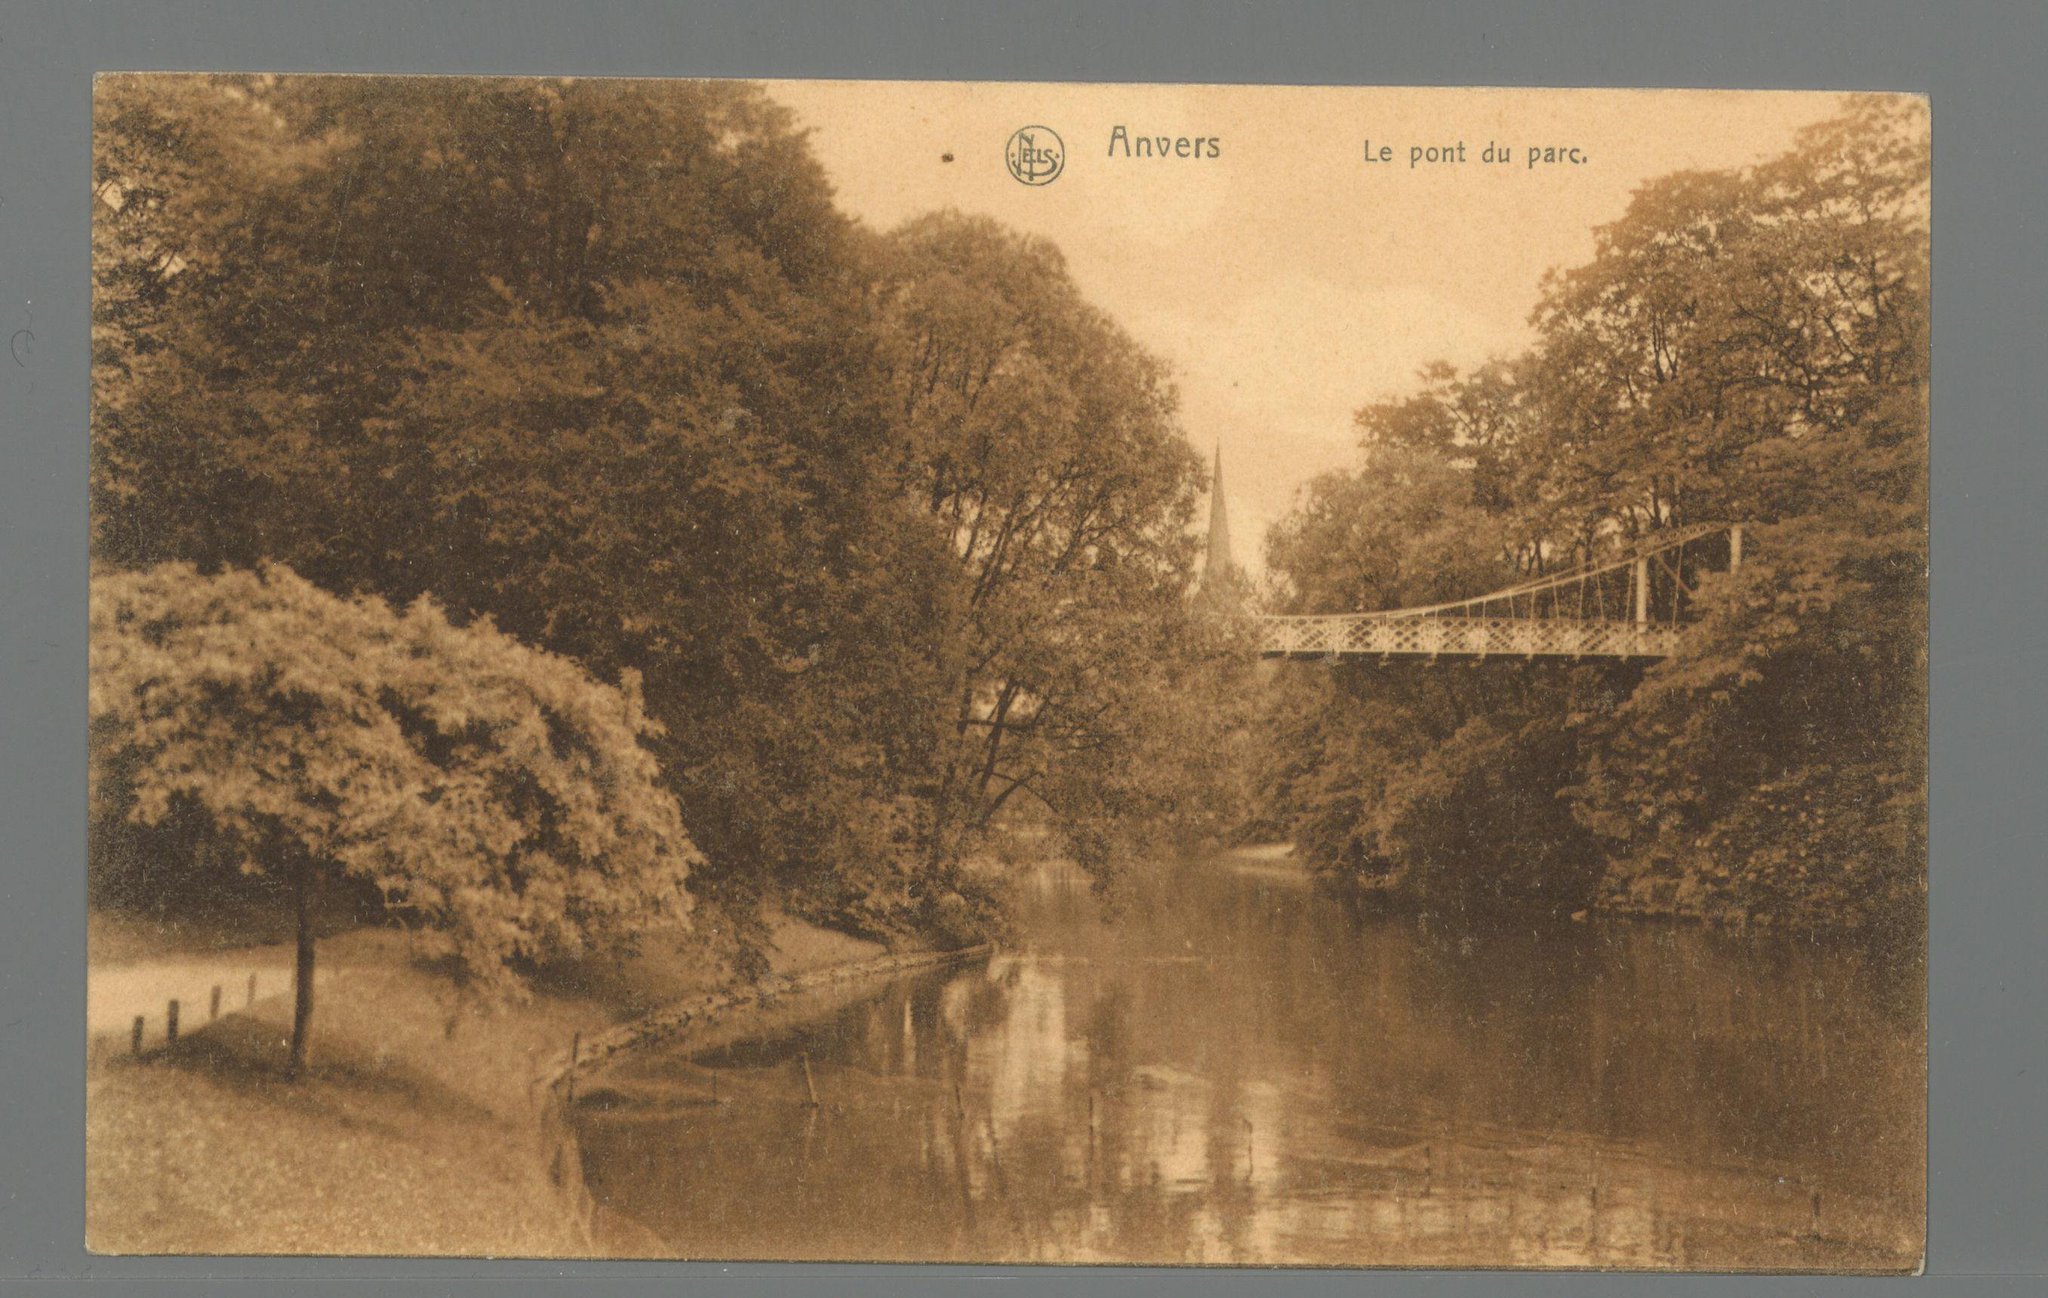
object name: ansichtkaart, prentbriefkaart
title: Anvers. Le pont du parc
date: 1907-1913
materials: cardboard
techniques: photograph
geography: brussels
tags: bridge, public gardens, park, antwerp